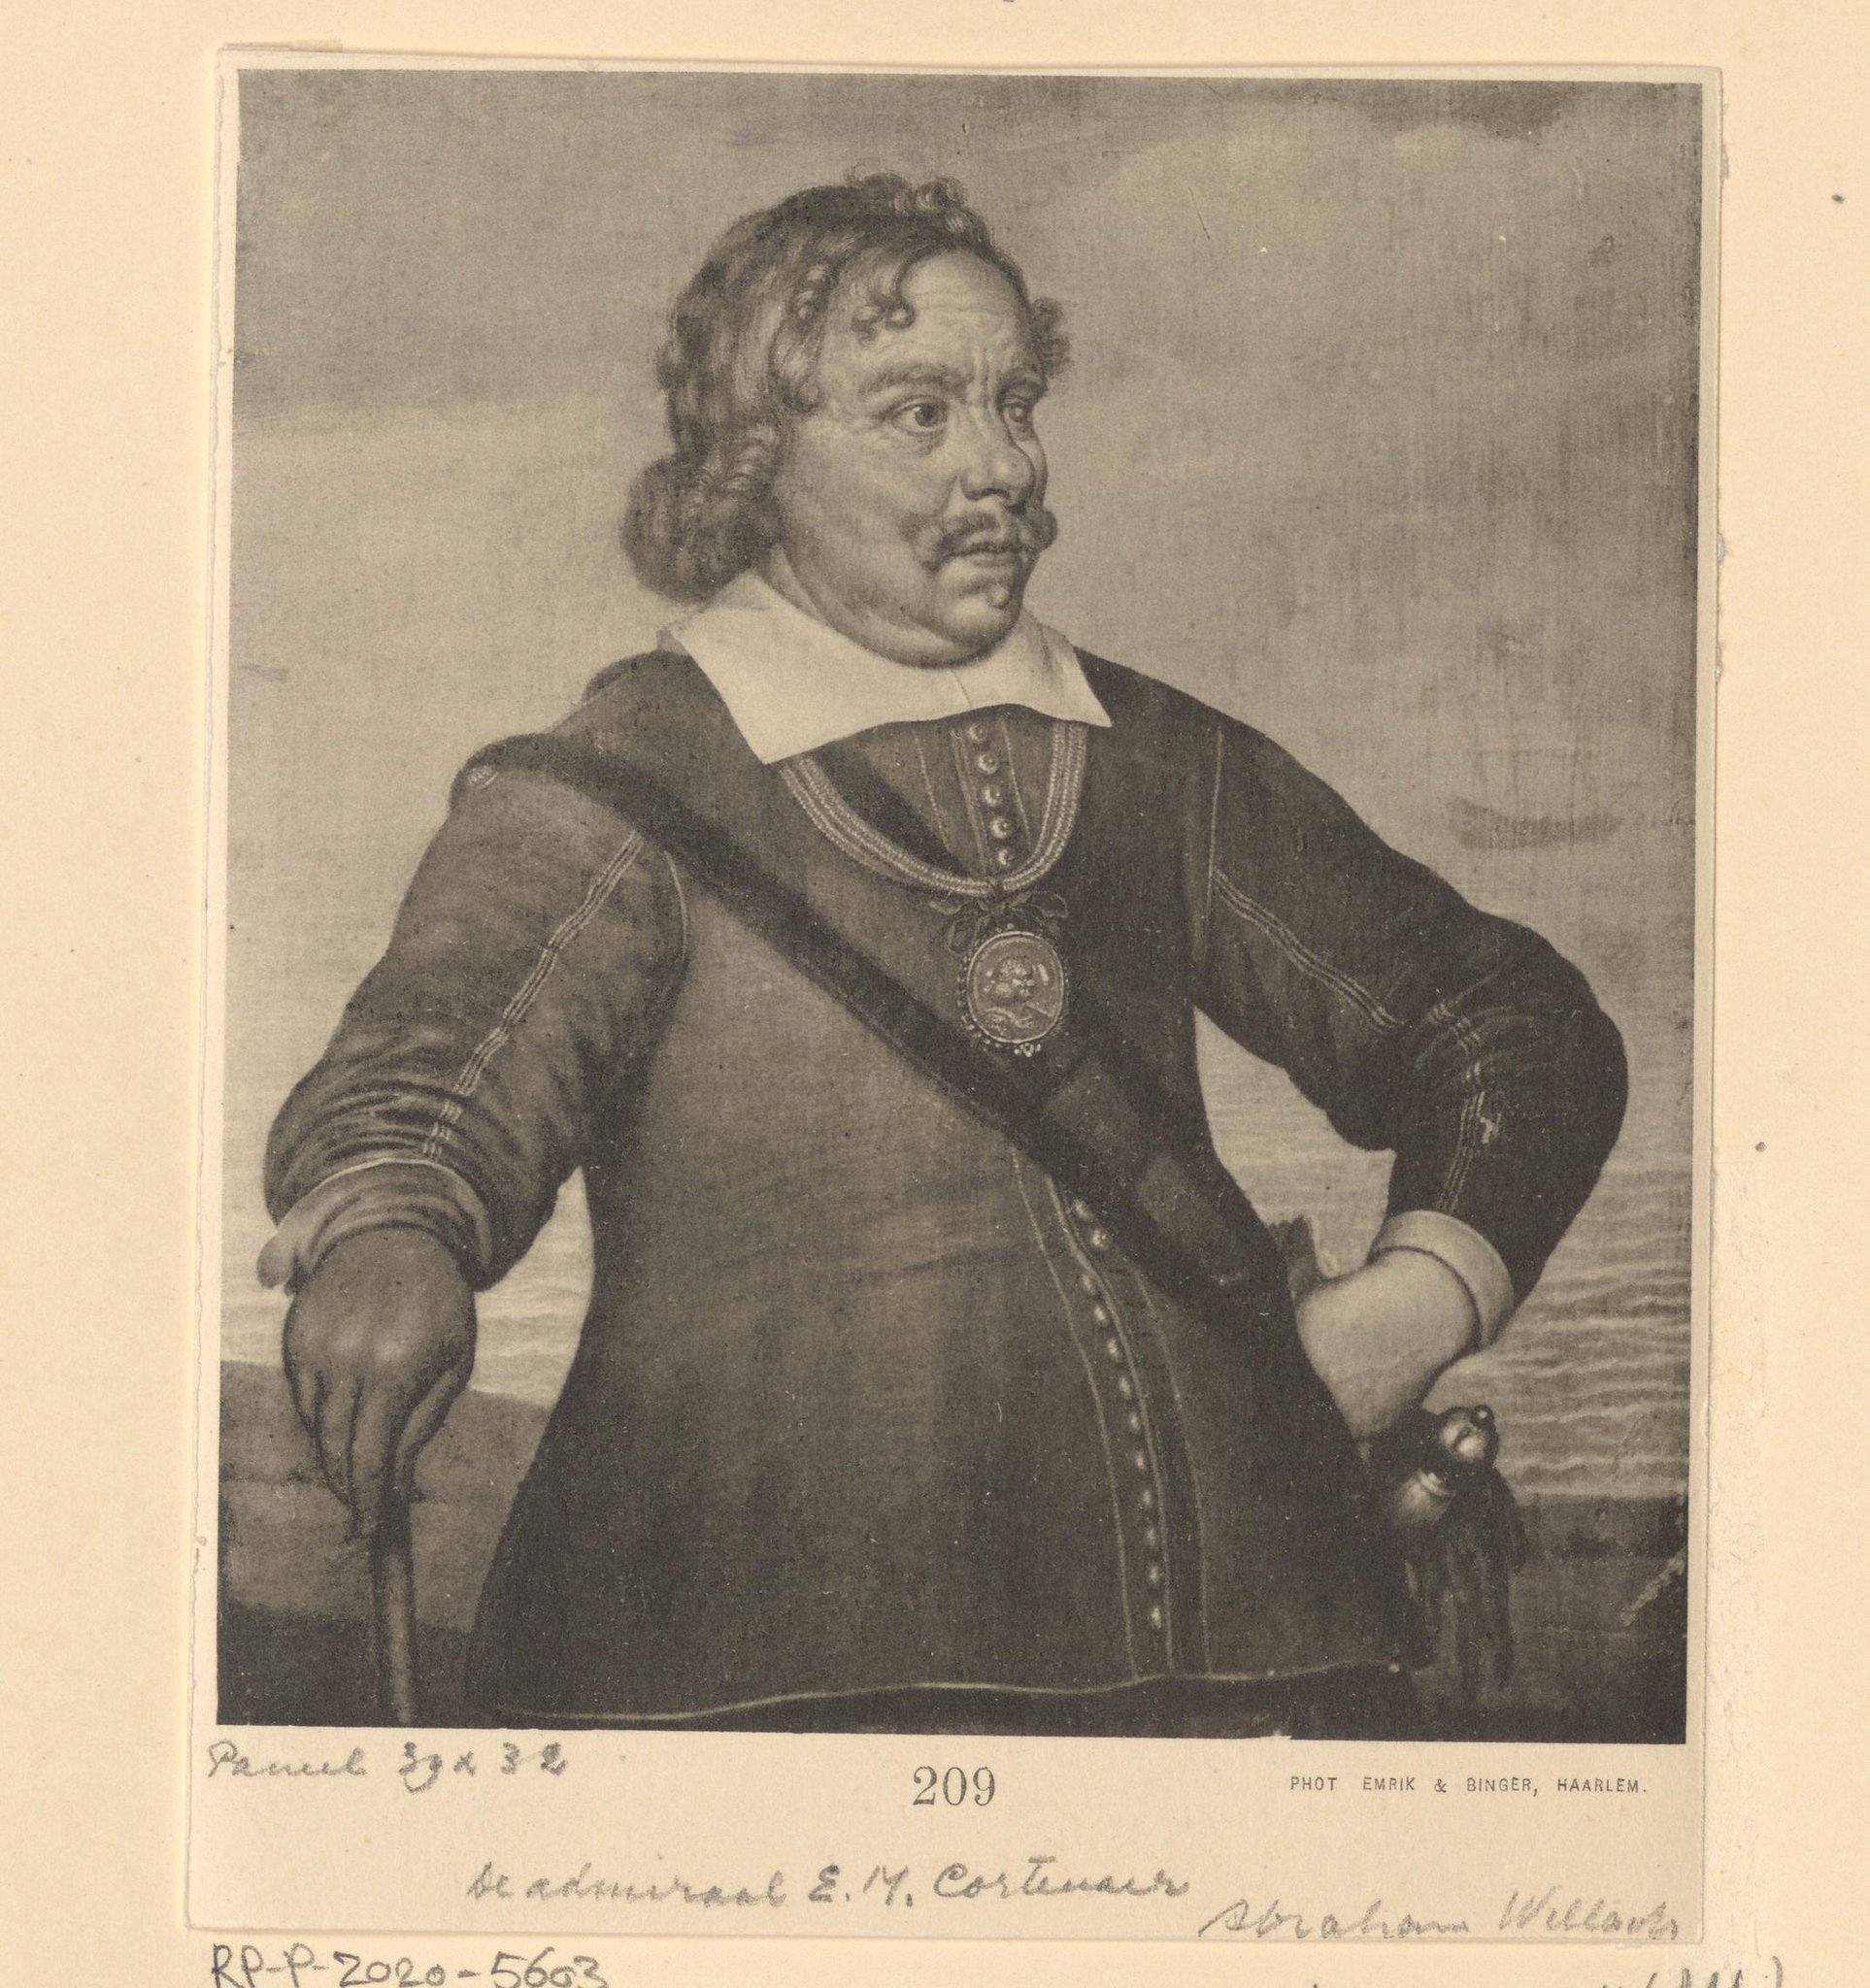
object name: photomechanical print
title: Portret van Egbert Meeusz Kortenaer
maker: Anonymous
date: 1857-1927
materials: paper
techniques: photograph, letterpress printing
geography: haarlem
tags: historical persons